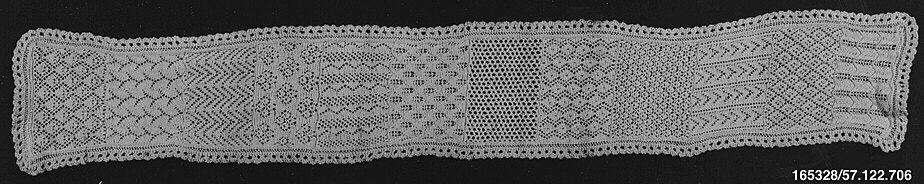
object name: sampler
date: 1801-1900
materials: cotton, lace